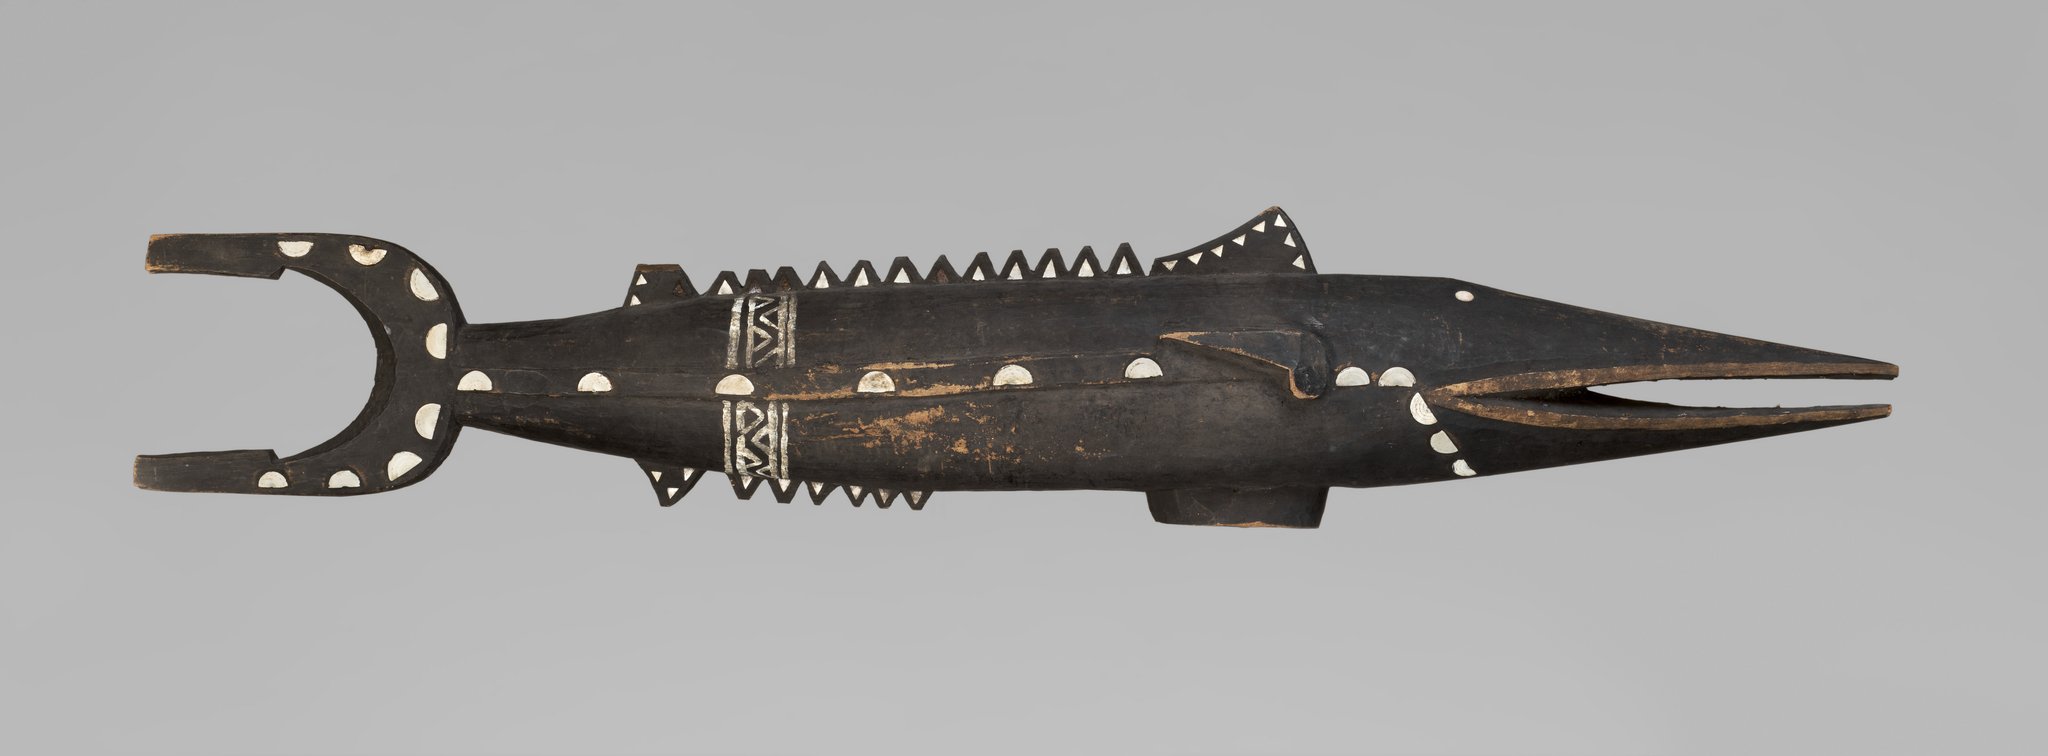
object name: reliquary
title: Shark Reliquary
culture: solomon islands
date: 1900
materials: pigment, shell, wood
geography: solomon islands